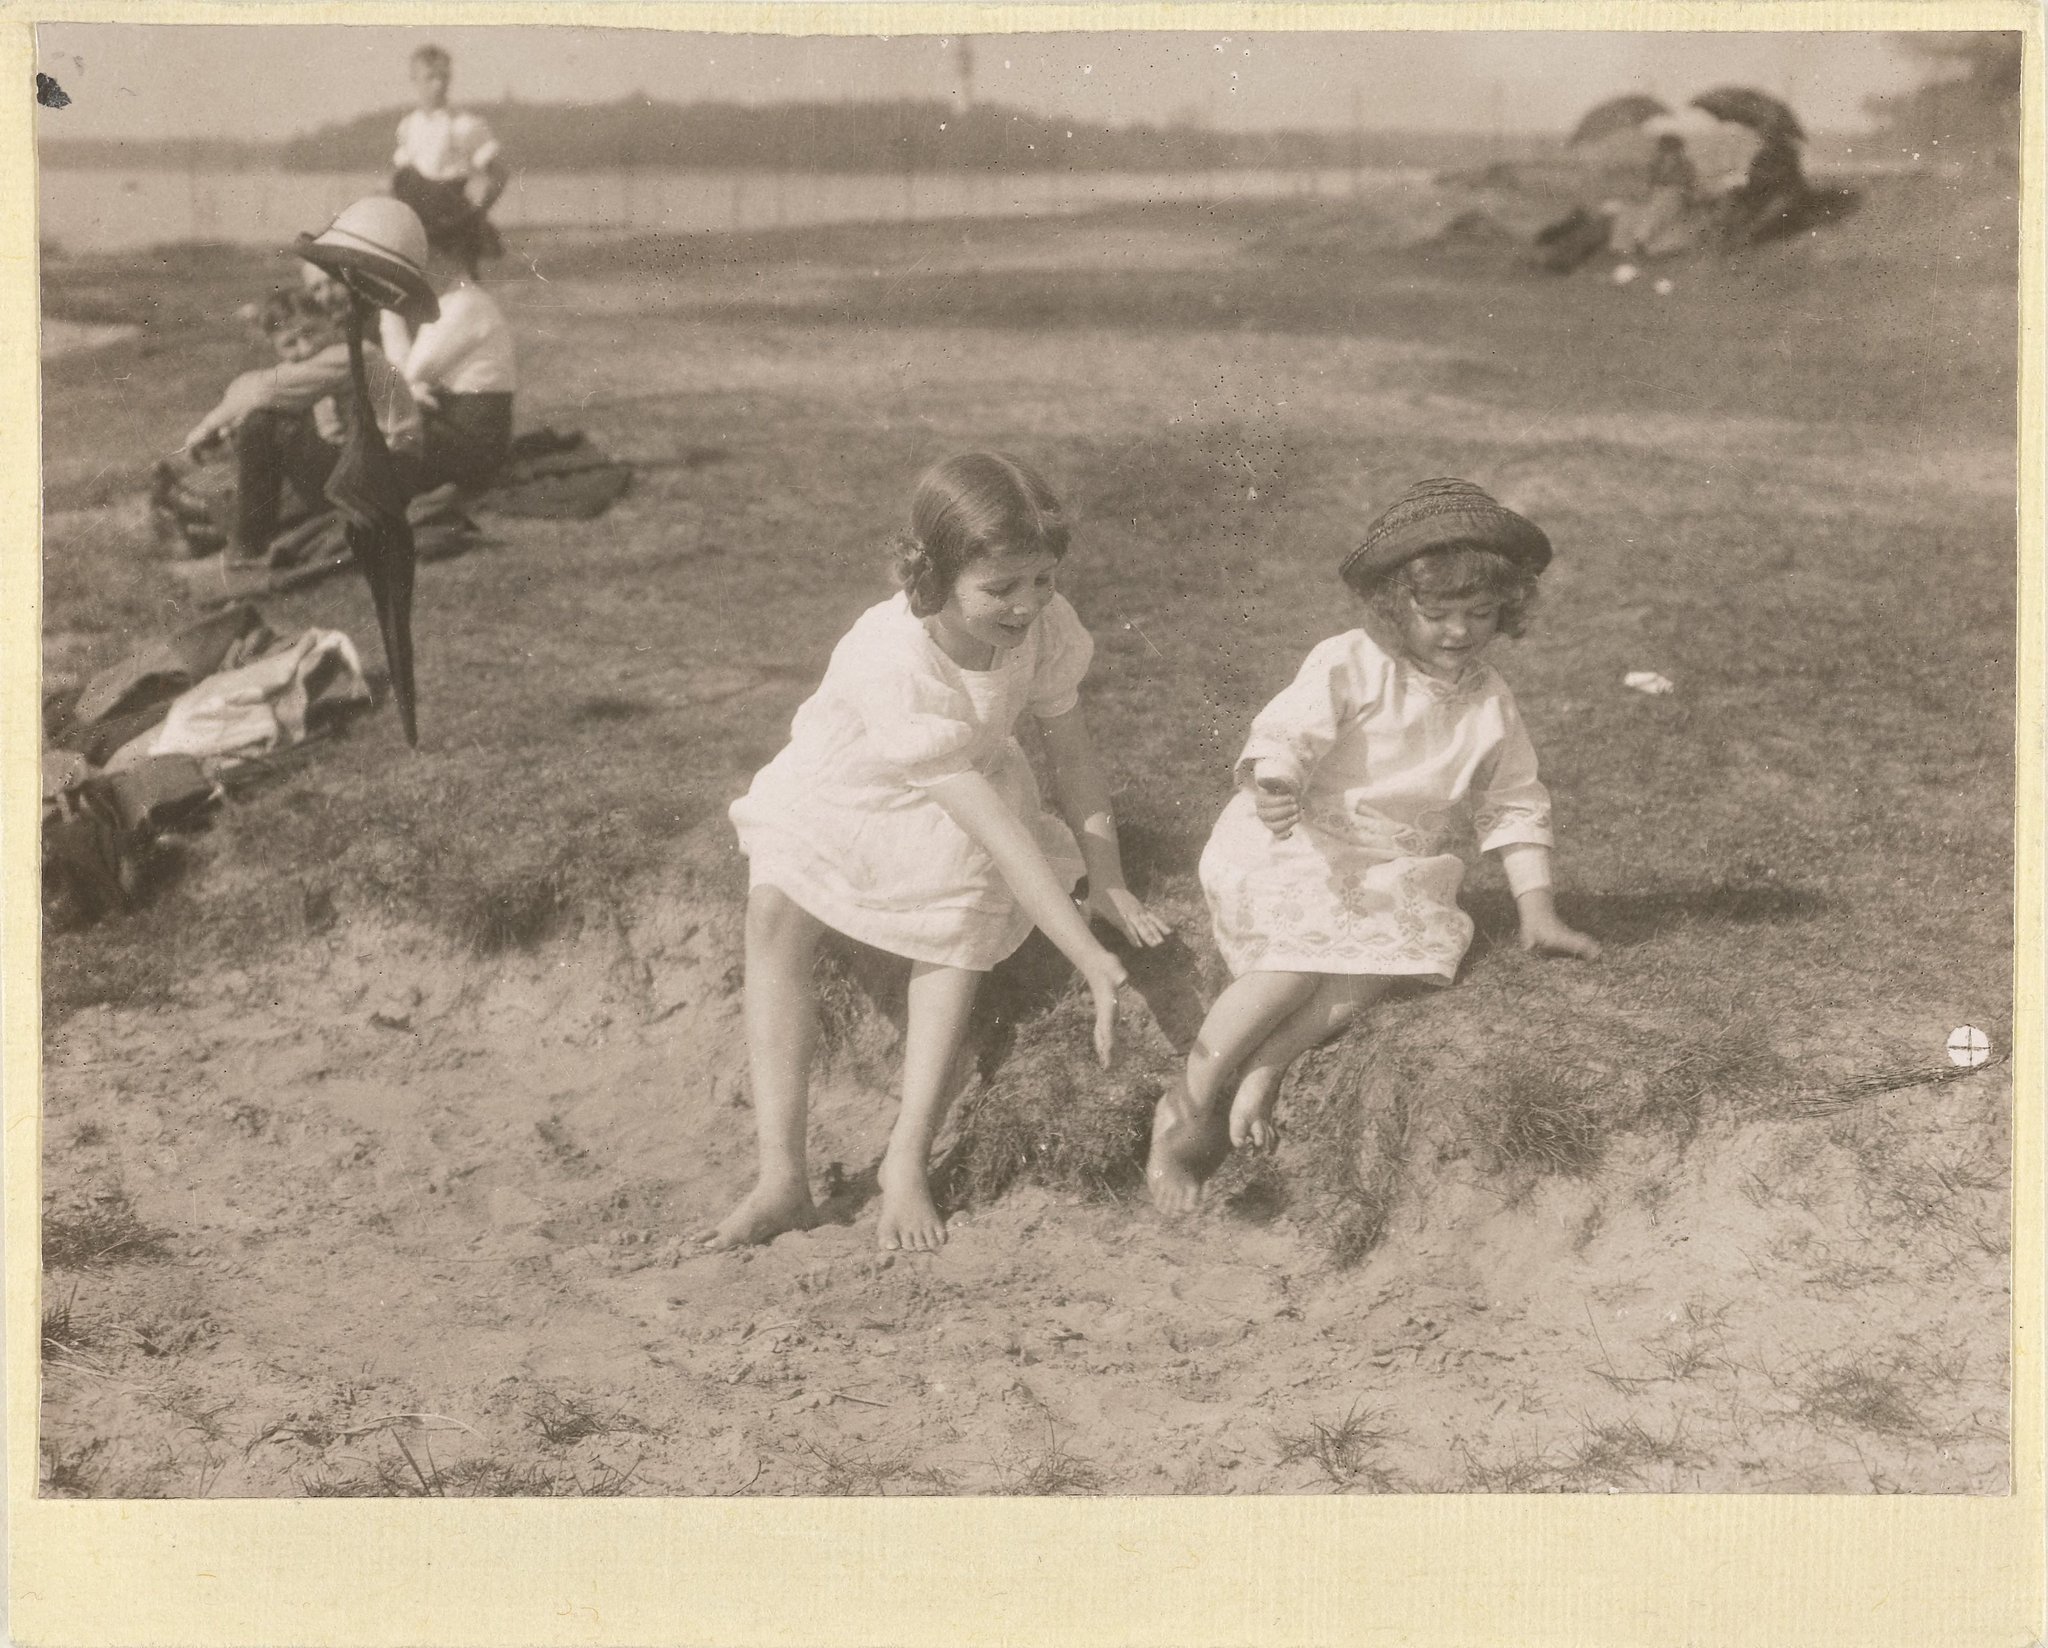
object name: photograph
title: Marba Titzenthaler, dochter van de fotograaf, en een onbekend meisje spelend op het strand bij een meer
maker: waldemar titzenthaler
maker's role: fotograaf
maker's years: 1869-1937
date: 1914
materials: paper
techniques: gelatin silver print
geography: germany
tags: beach (as place of recreation), girl (child between toddler and youth), germany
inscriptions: date: ‘13.4.14’